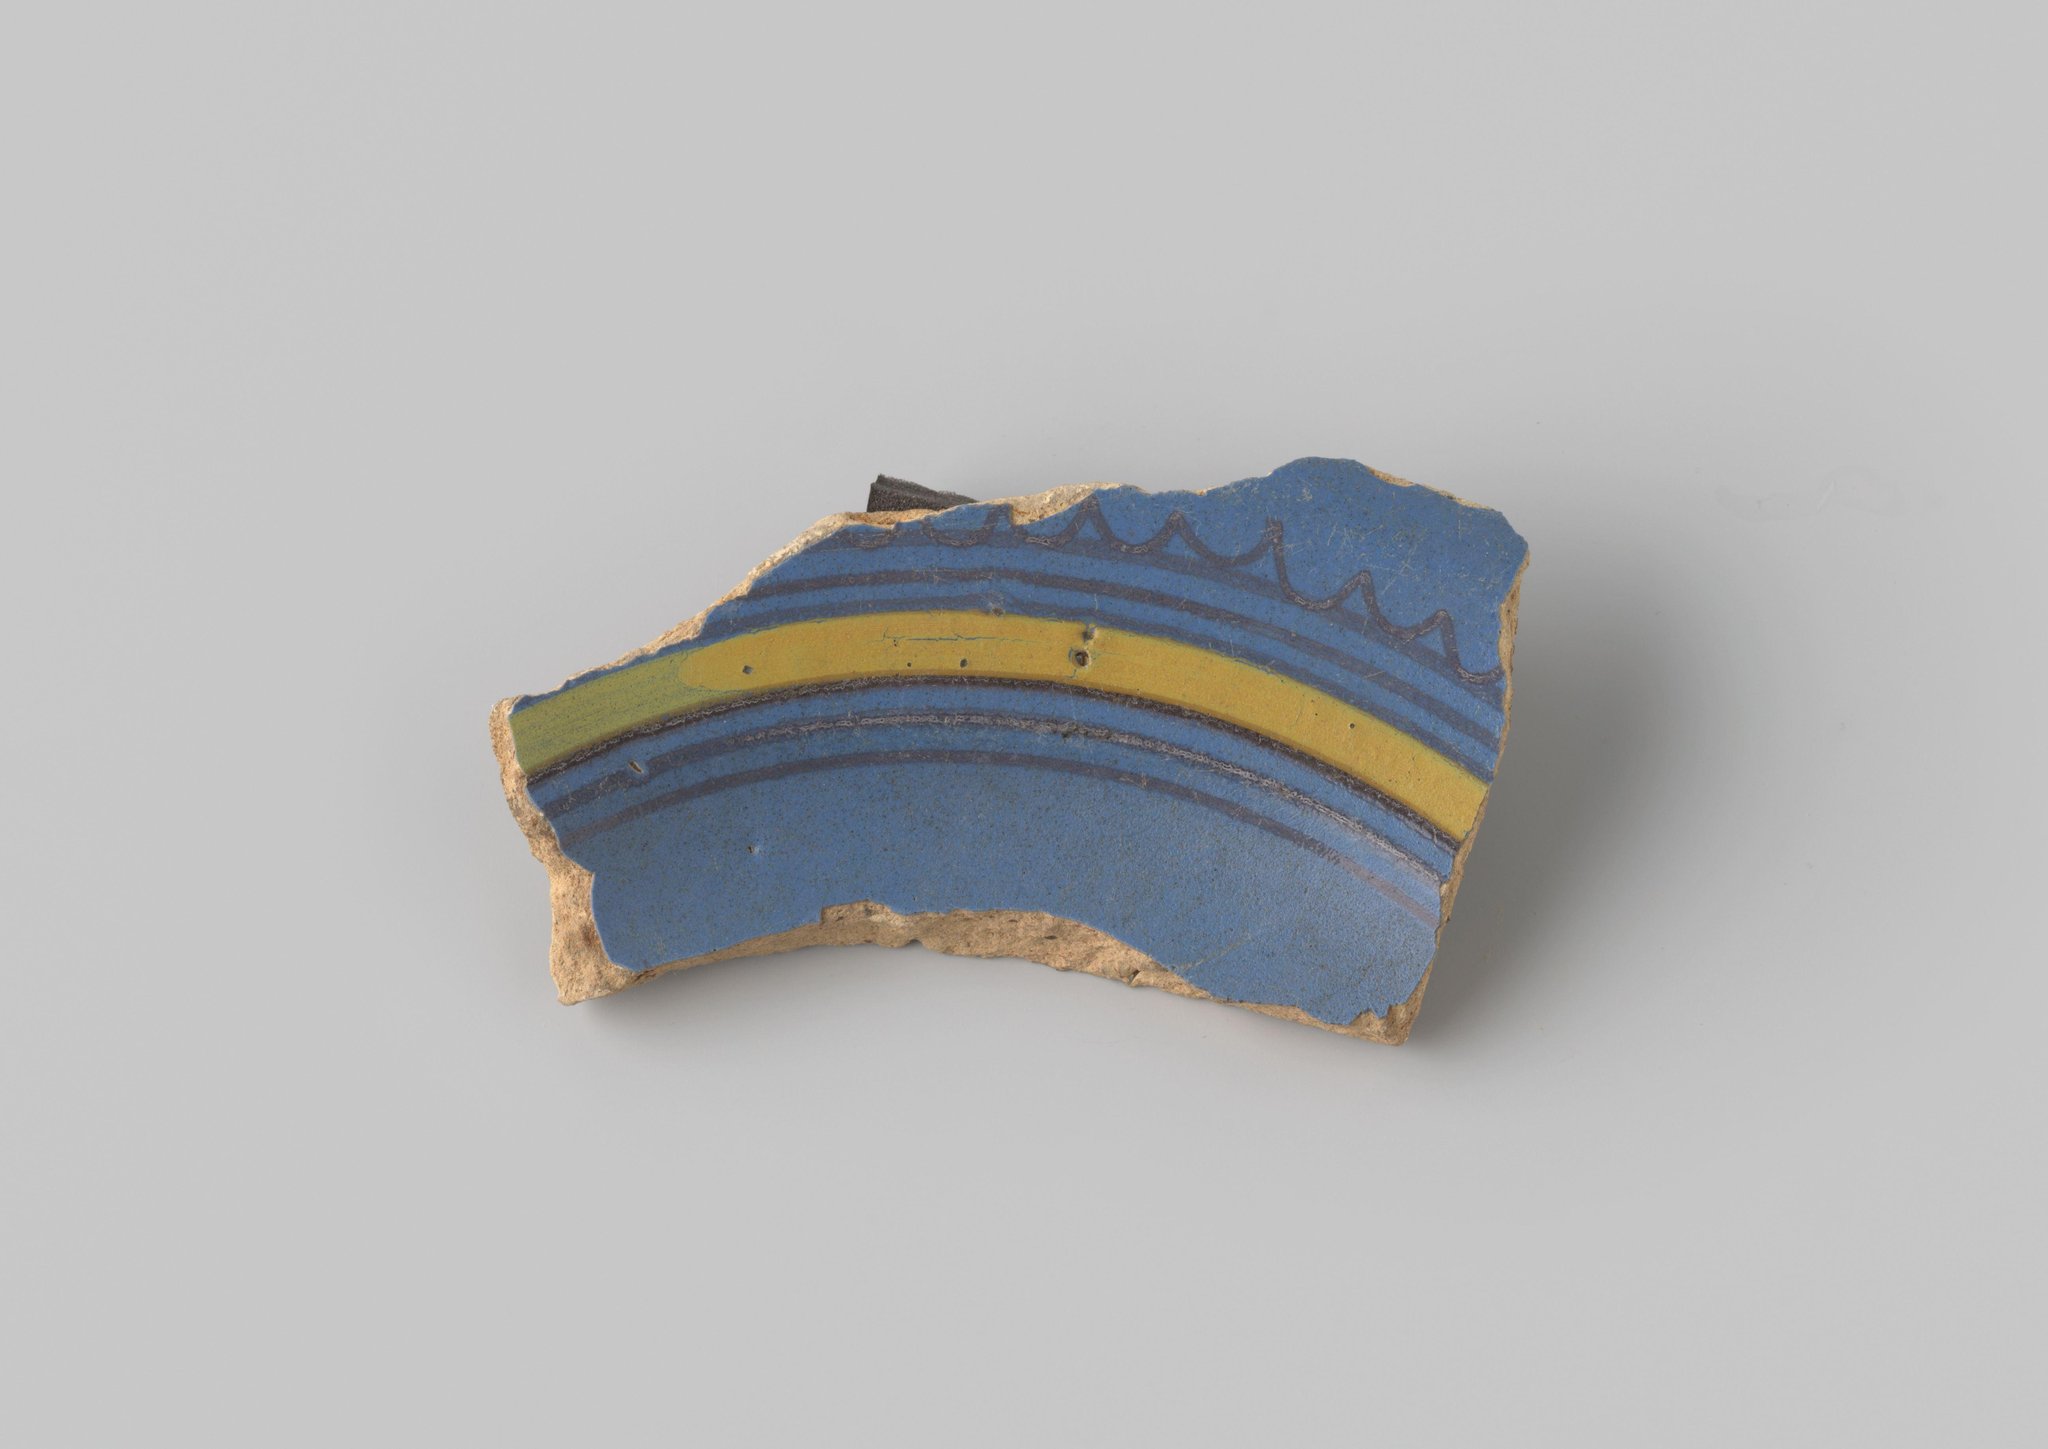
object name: fragment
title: Scherf van rossigbakkend aardewerk, aan de voorzijde voorzien van blauw glazuur, waarop strepen en gegolfde lijnen in bruin en geel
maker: Anonymous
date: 1600-1650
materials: earthenware, glaze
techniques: maiolica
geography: northern netherlands